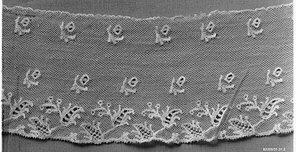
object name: edging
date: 1767-1800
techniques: lace